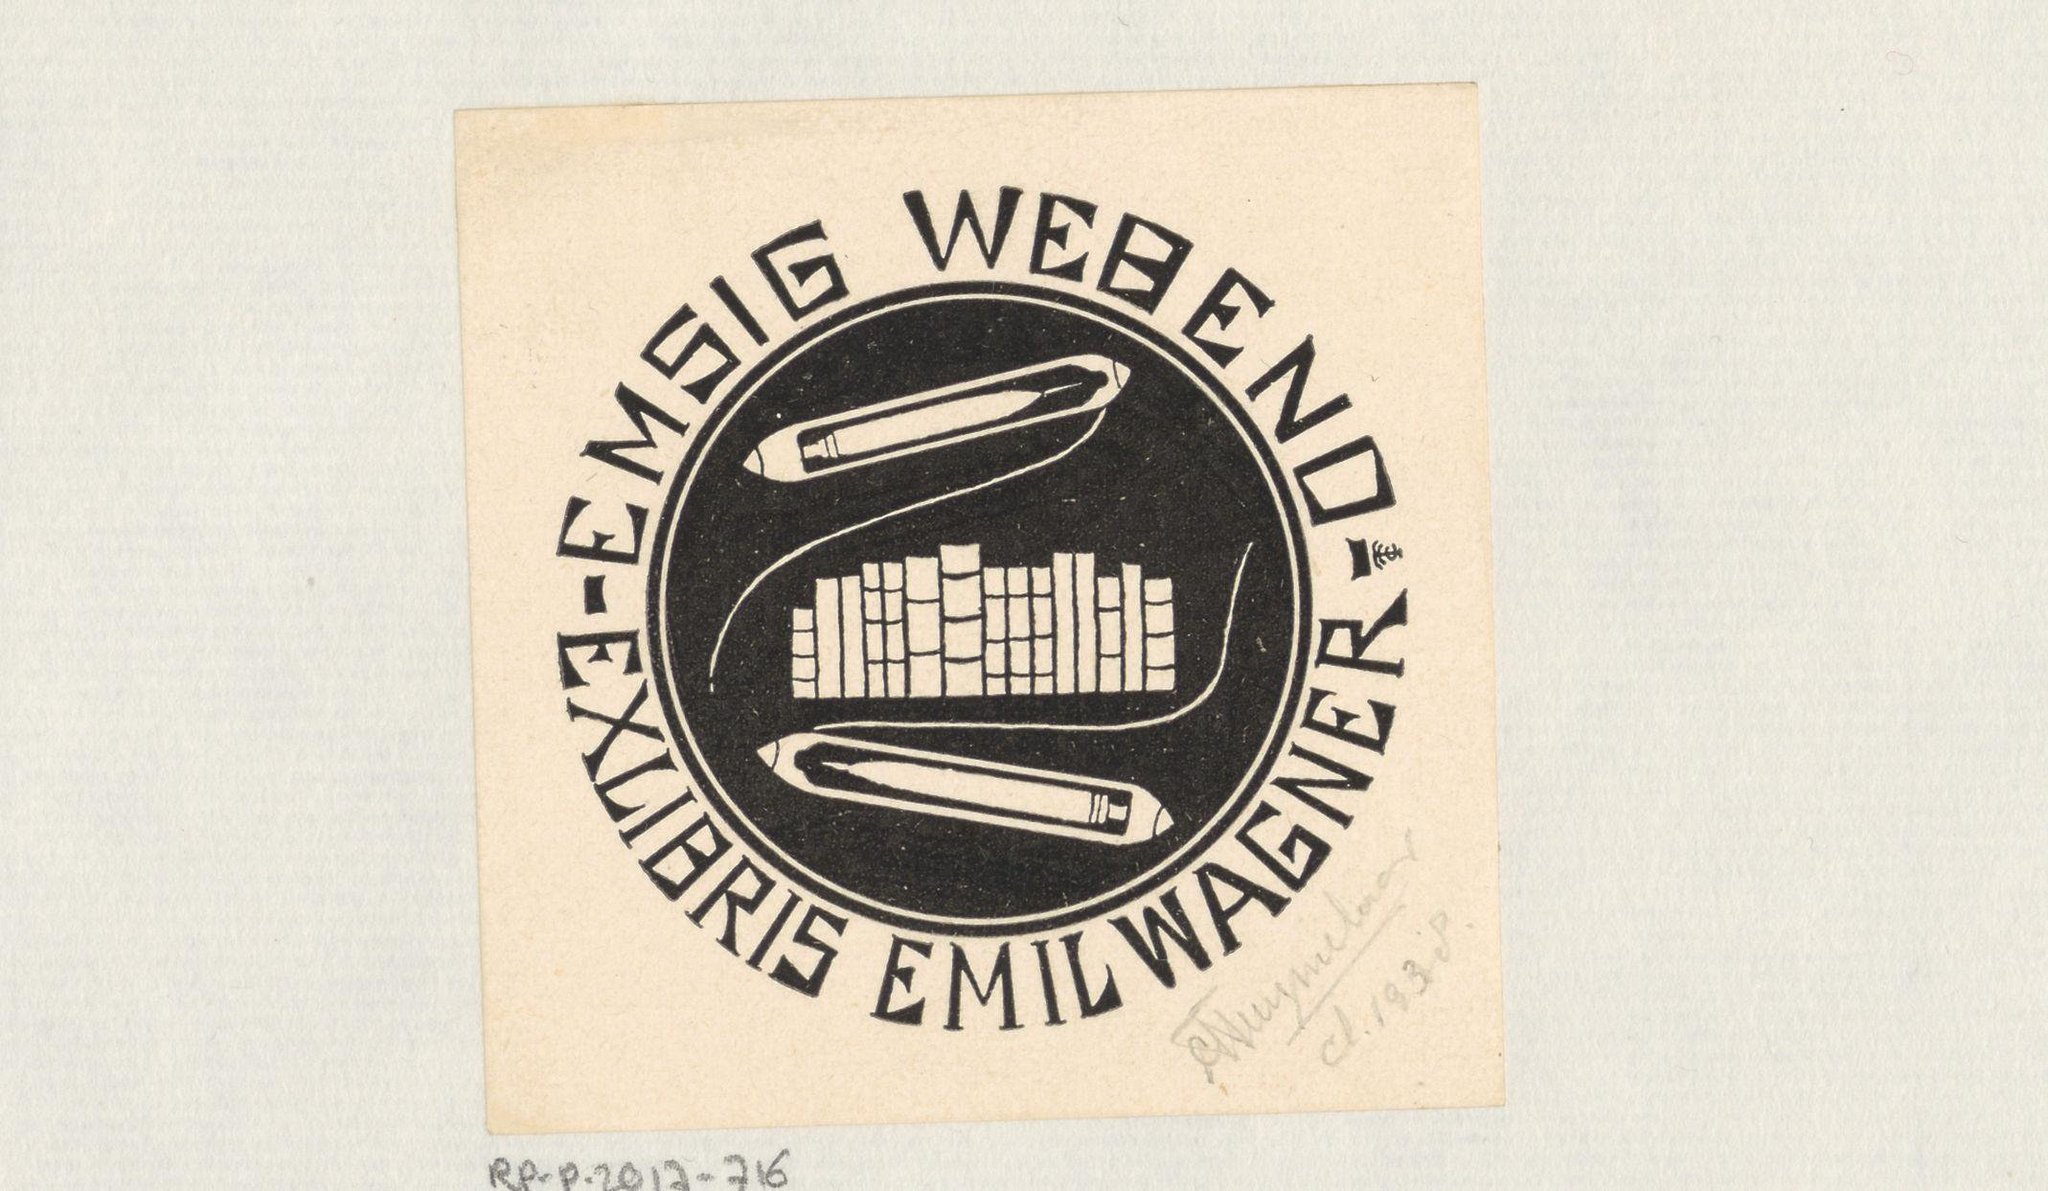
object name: bookplate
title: Emsig webend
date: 1938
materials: paper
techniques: printing block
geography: netherlands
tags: book, weaving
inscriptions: signature and date: ‘C.Tj. Tuymelaar / cl. 1938’